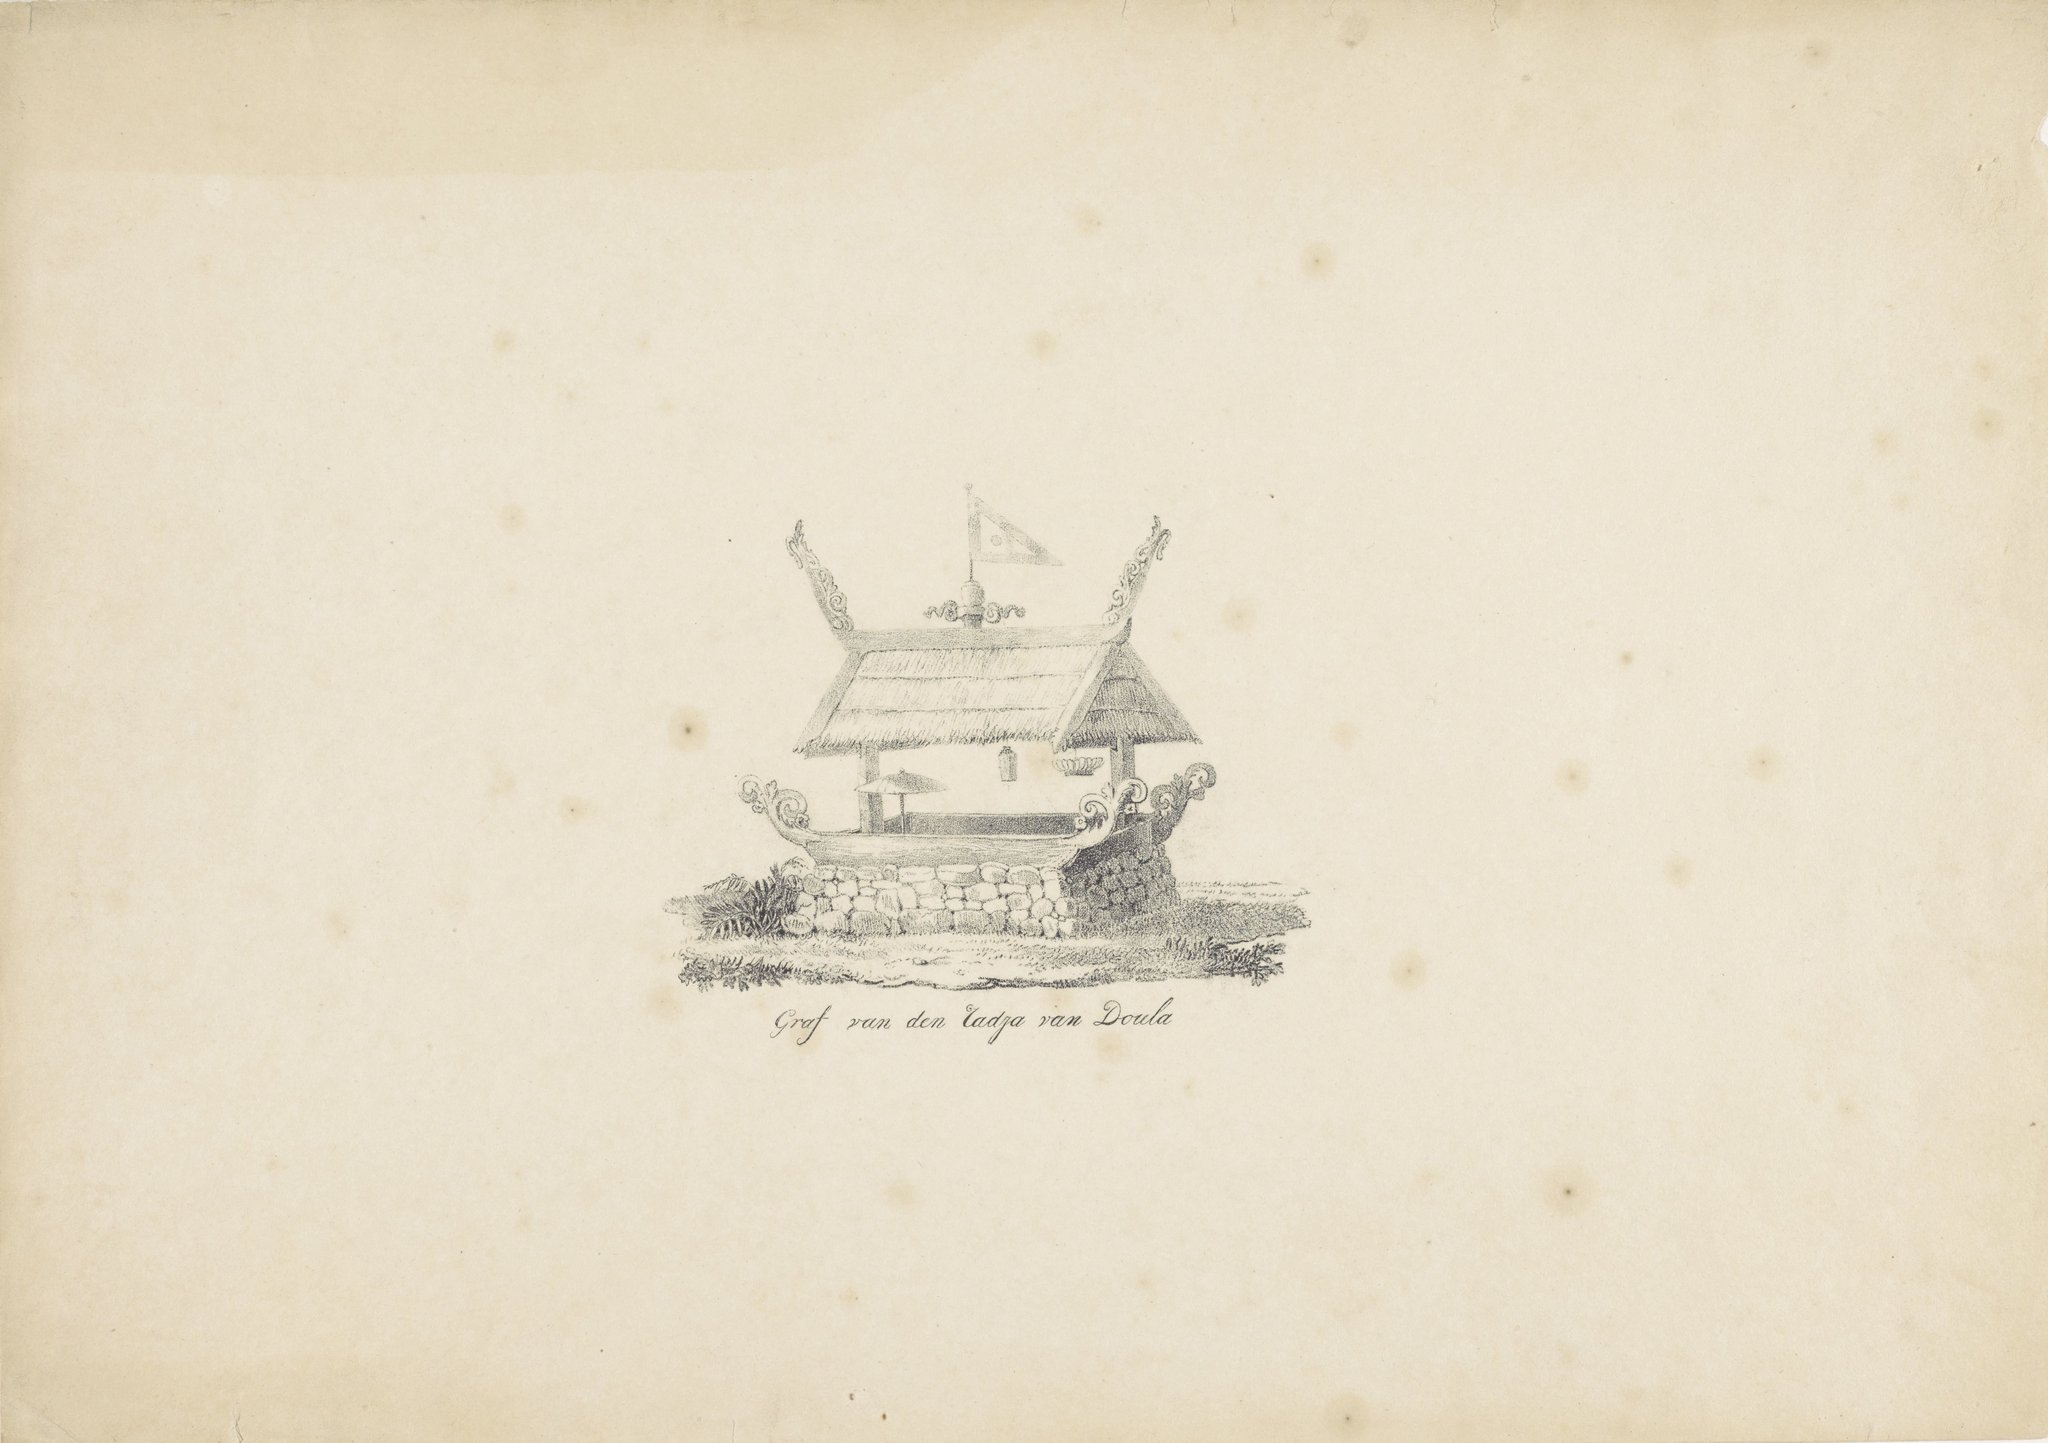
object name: print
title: Graf van den radja van Doula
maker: adrianus johannes bik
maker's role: draughtsman, print maker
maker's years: 1790-1872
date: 1824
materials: paper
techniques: lithograph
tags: grave, tomb, indonesia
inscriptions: collector's mark: Lugt 2228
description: De onderkant van het graf bestaat uit gemetselde stenen. Daar bovenop een houten constructie met een rieten dak. Onder de kap hangen lampionnen. Op het dak staat een vlag.